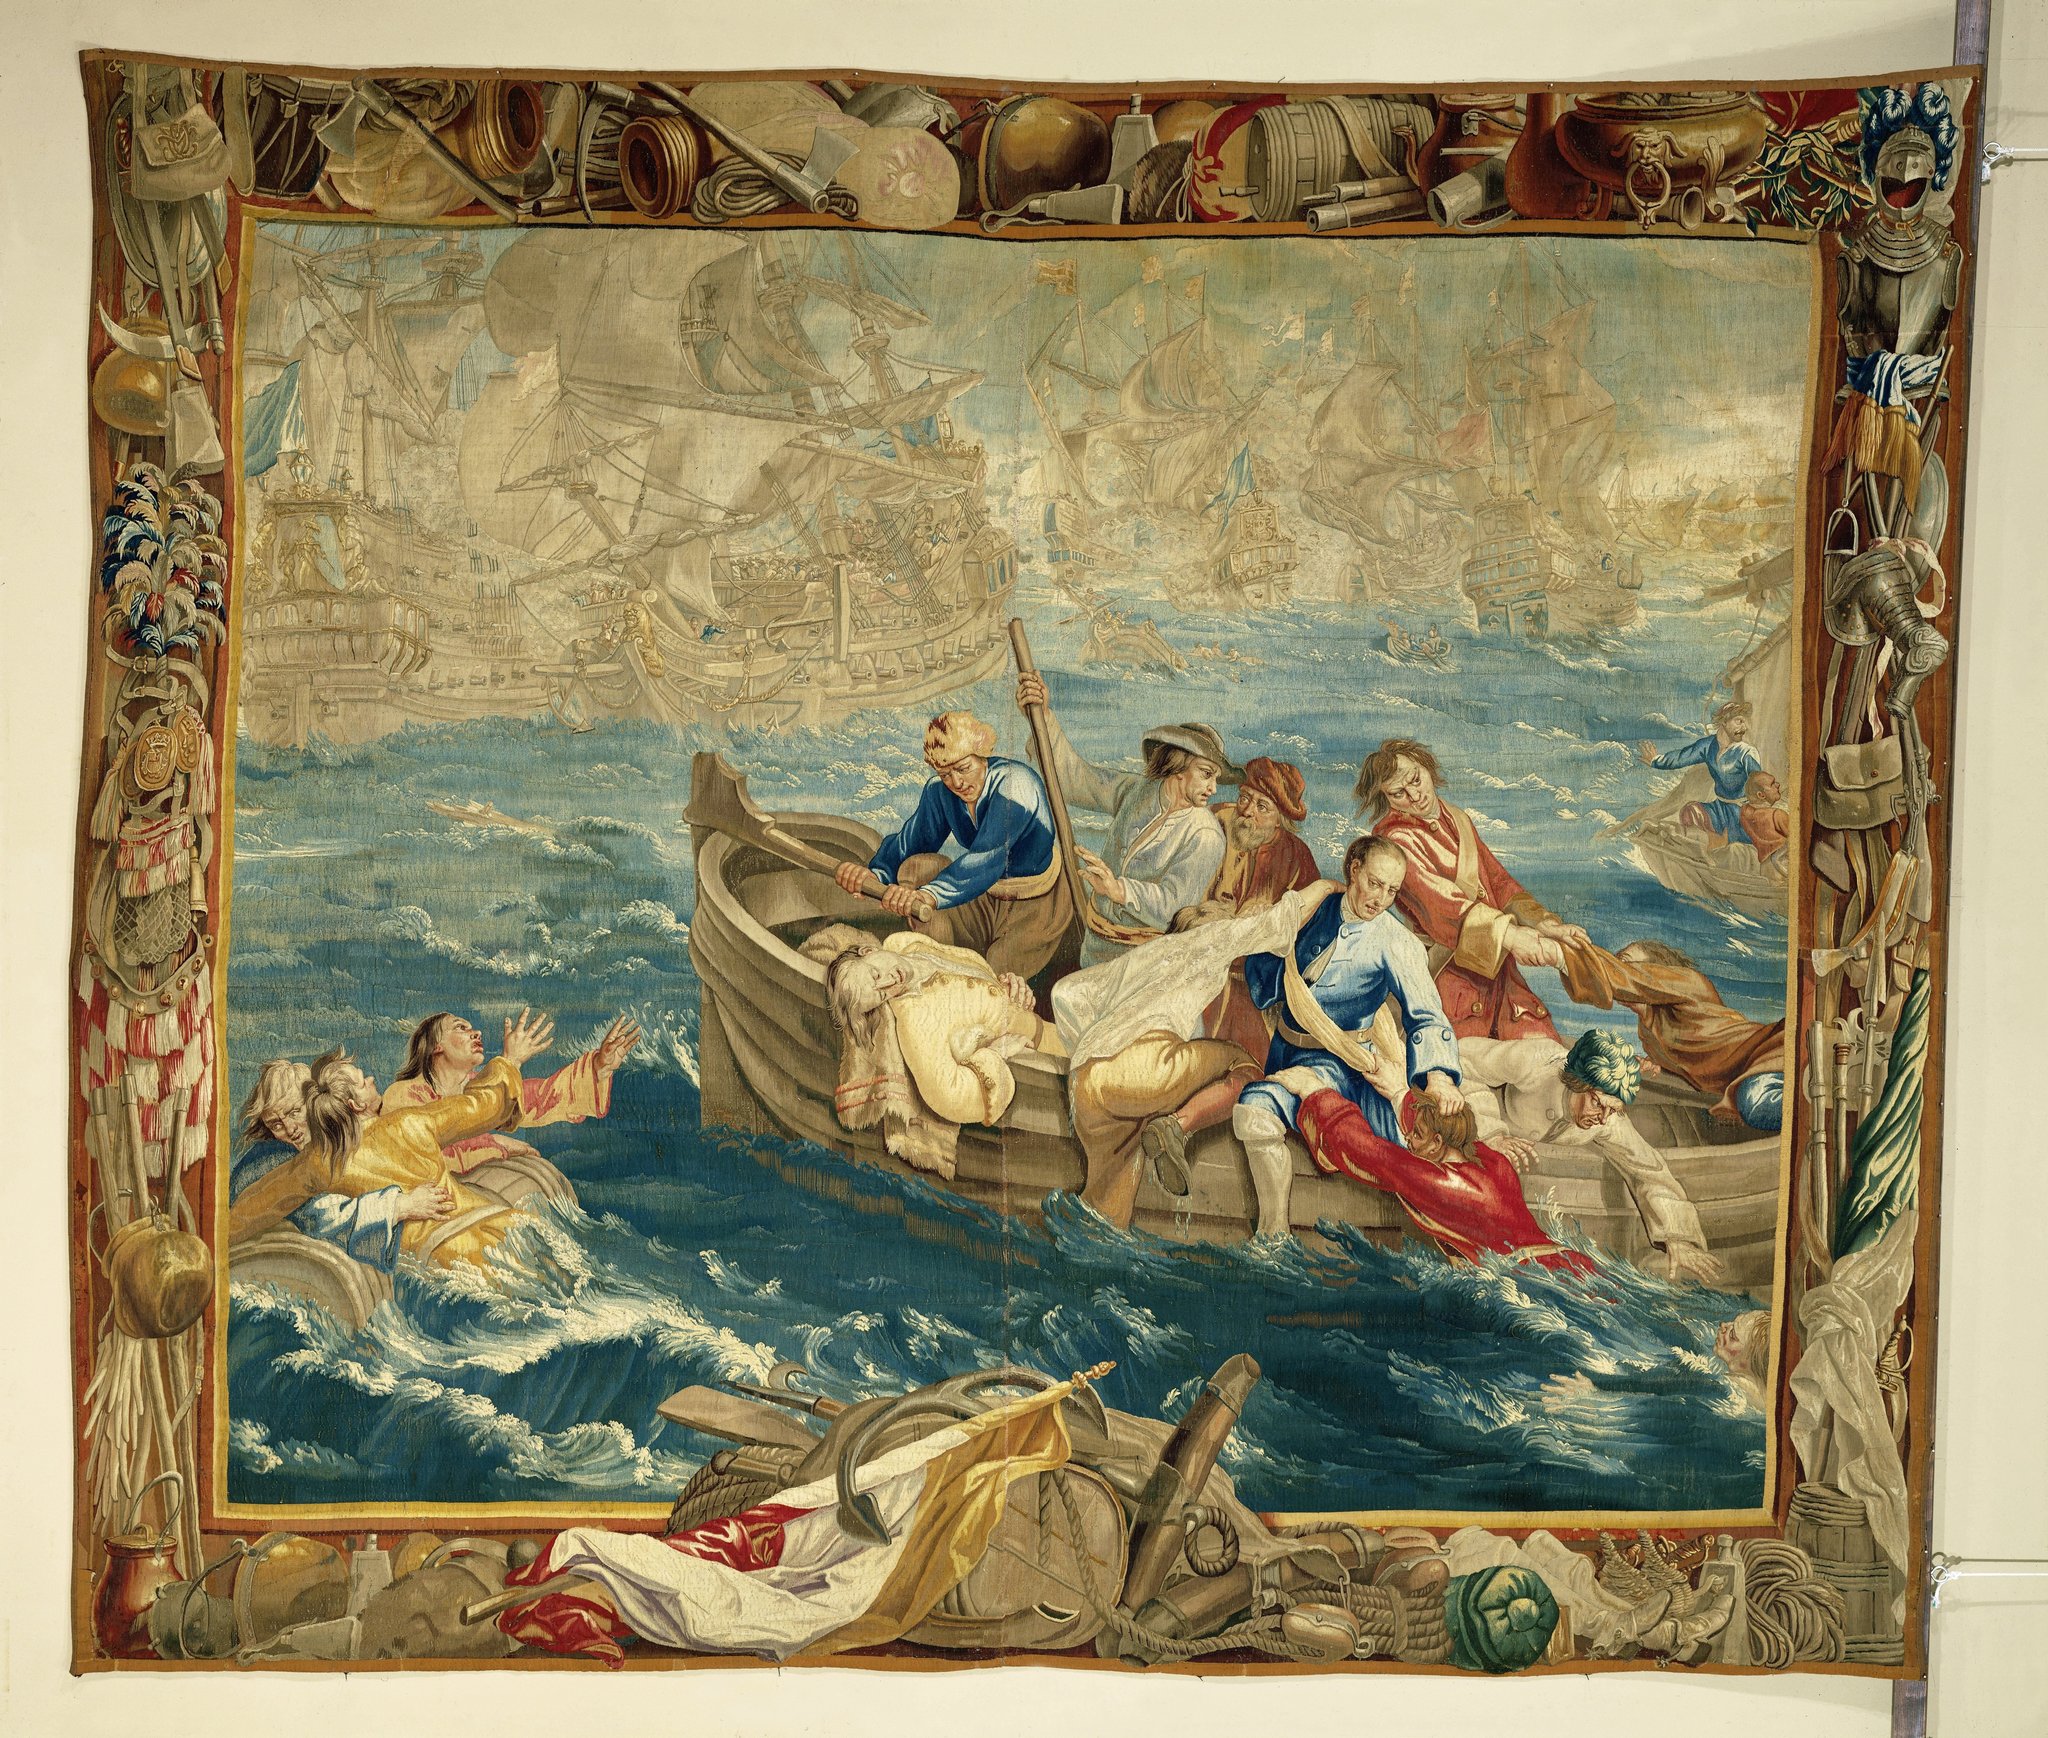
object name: tapestry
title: De krijgskunst II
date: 1715-1734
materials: silk, wool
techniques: tapestry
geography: brussels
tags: drowning, shipwrecked person, battle (+ sailing-ships)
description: Jeri Bapasola, Tapestry in the Baroque: threads of splendor, New York 2007, p. 477-483, cat. 57. Vermeldt en toont een vergelijkbaar wandtapijt.